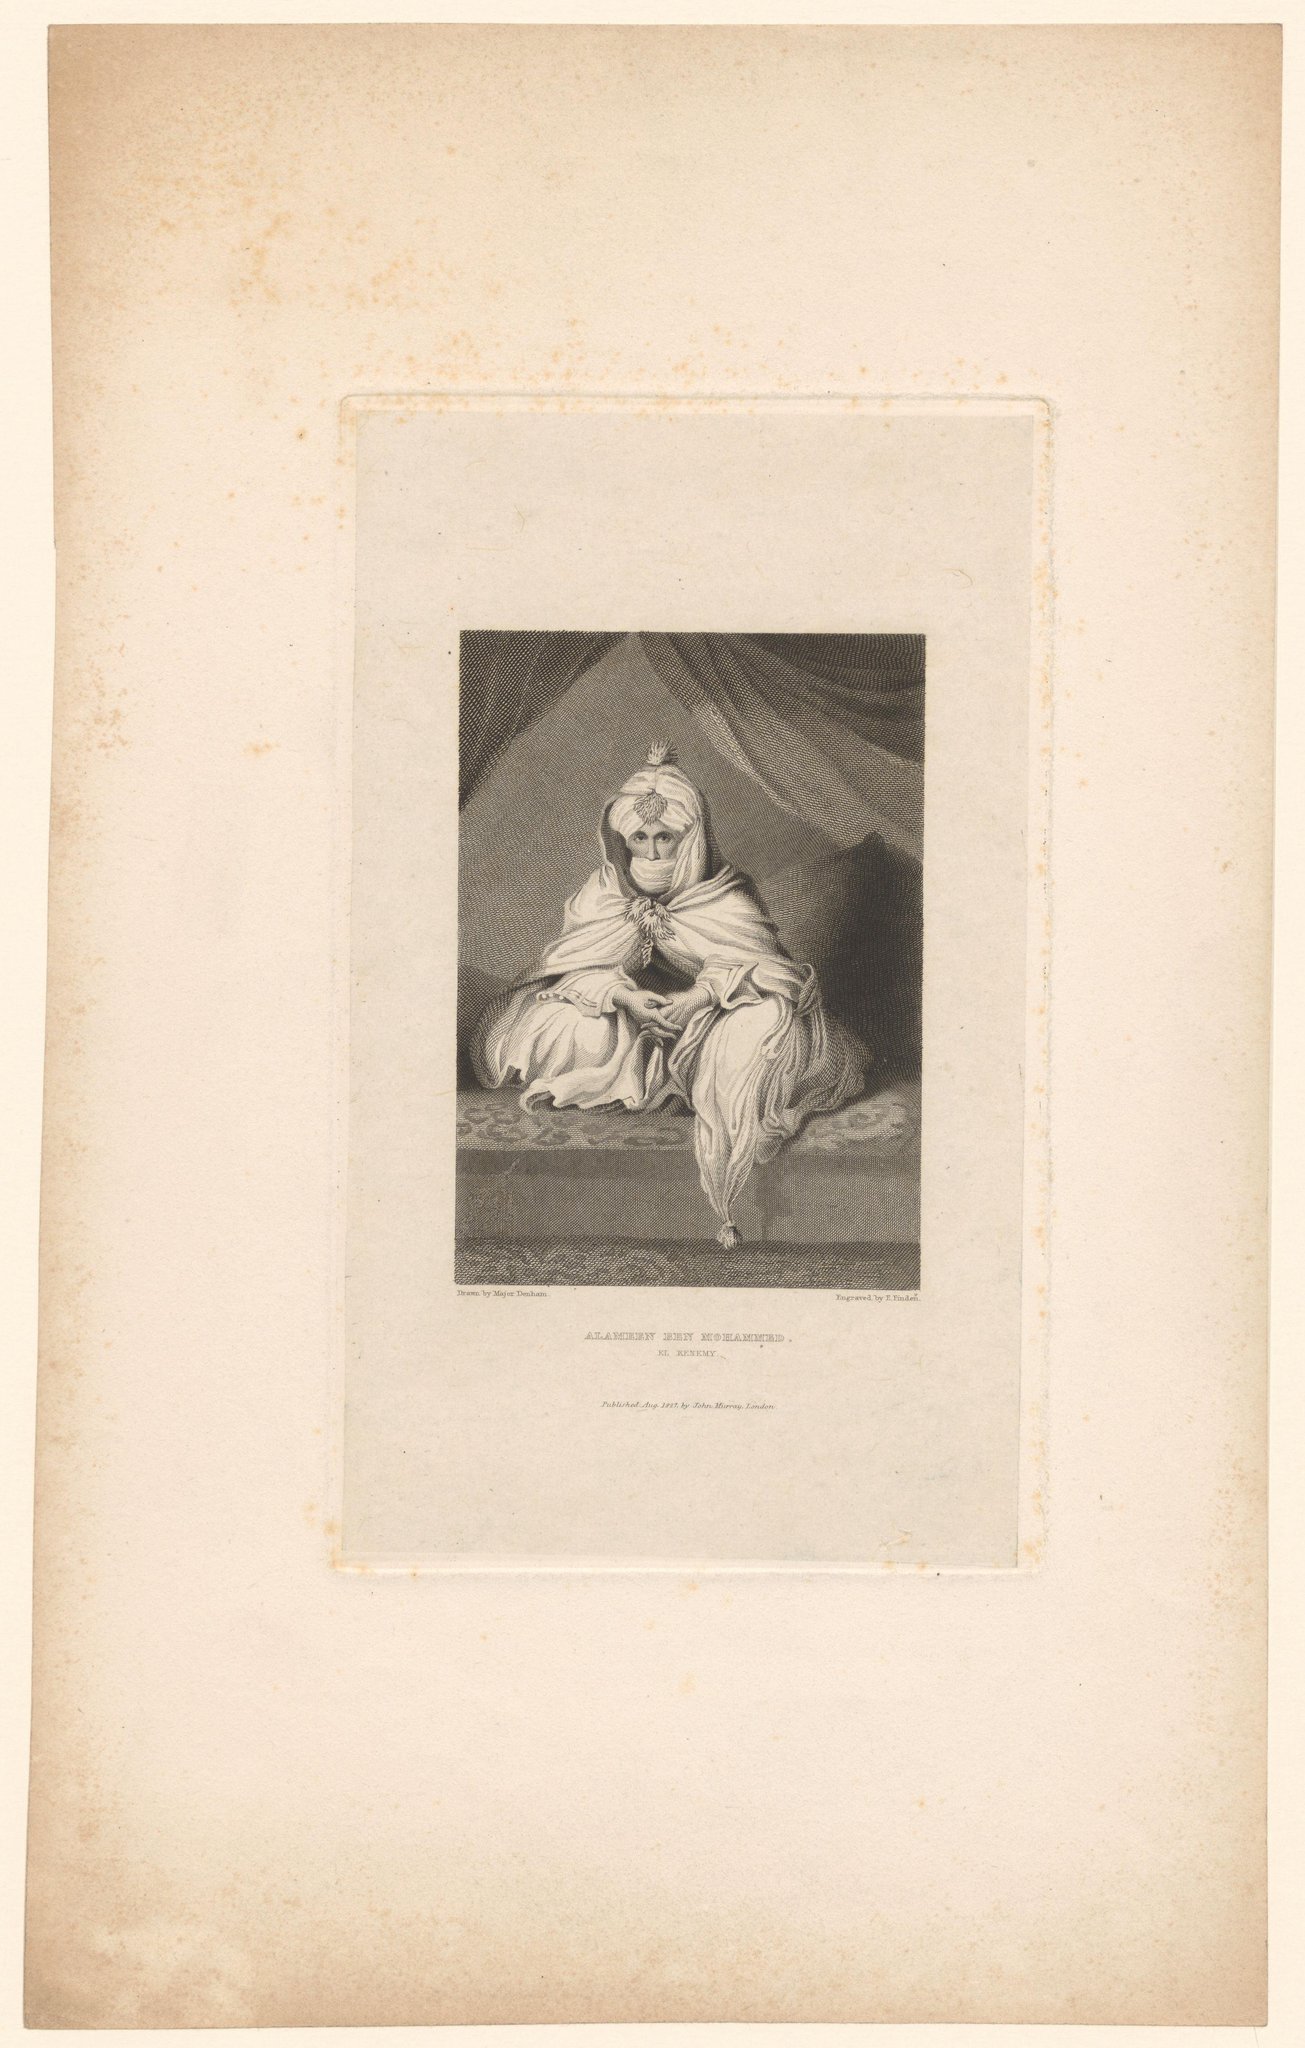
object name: print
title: Alameen Ben Mohammed el Kenemy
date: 1808-1827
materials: paper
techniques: engraving, etching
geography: london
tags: politician, historical persons, politician, e.g. party leader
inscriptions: collector's mark: Lugt 2228